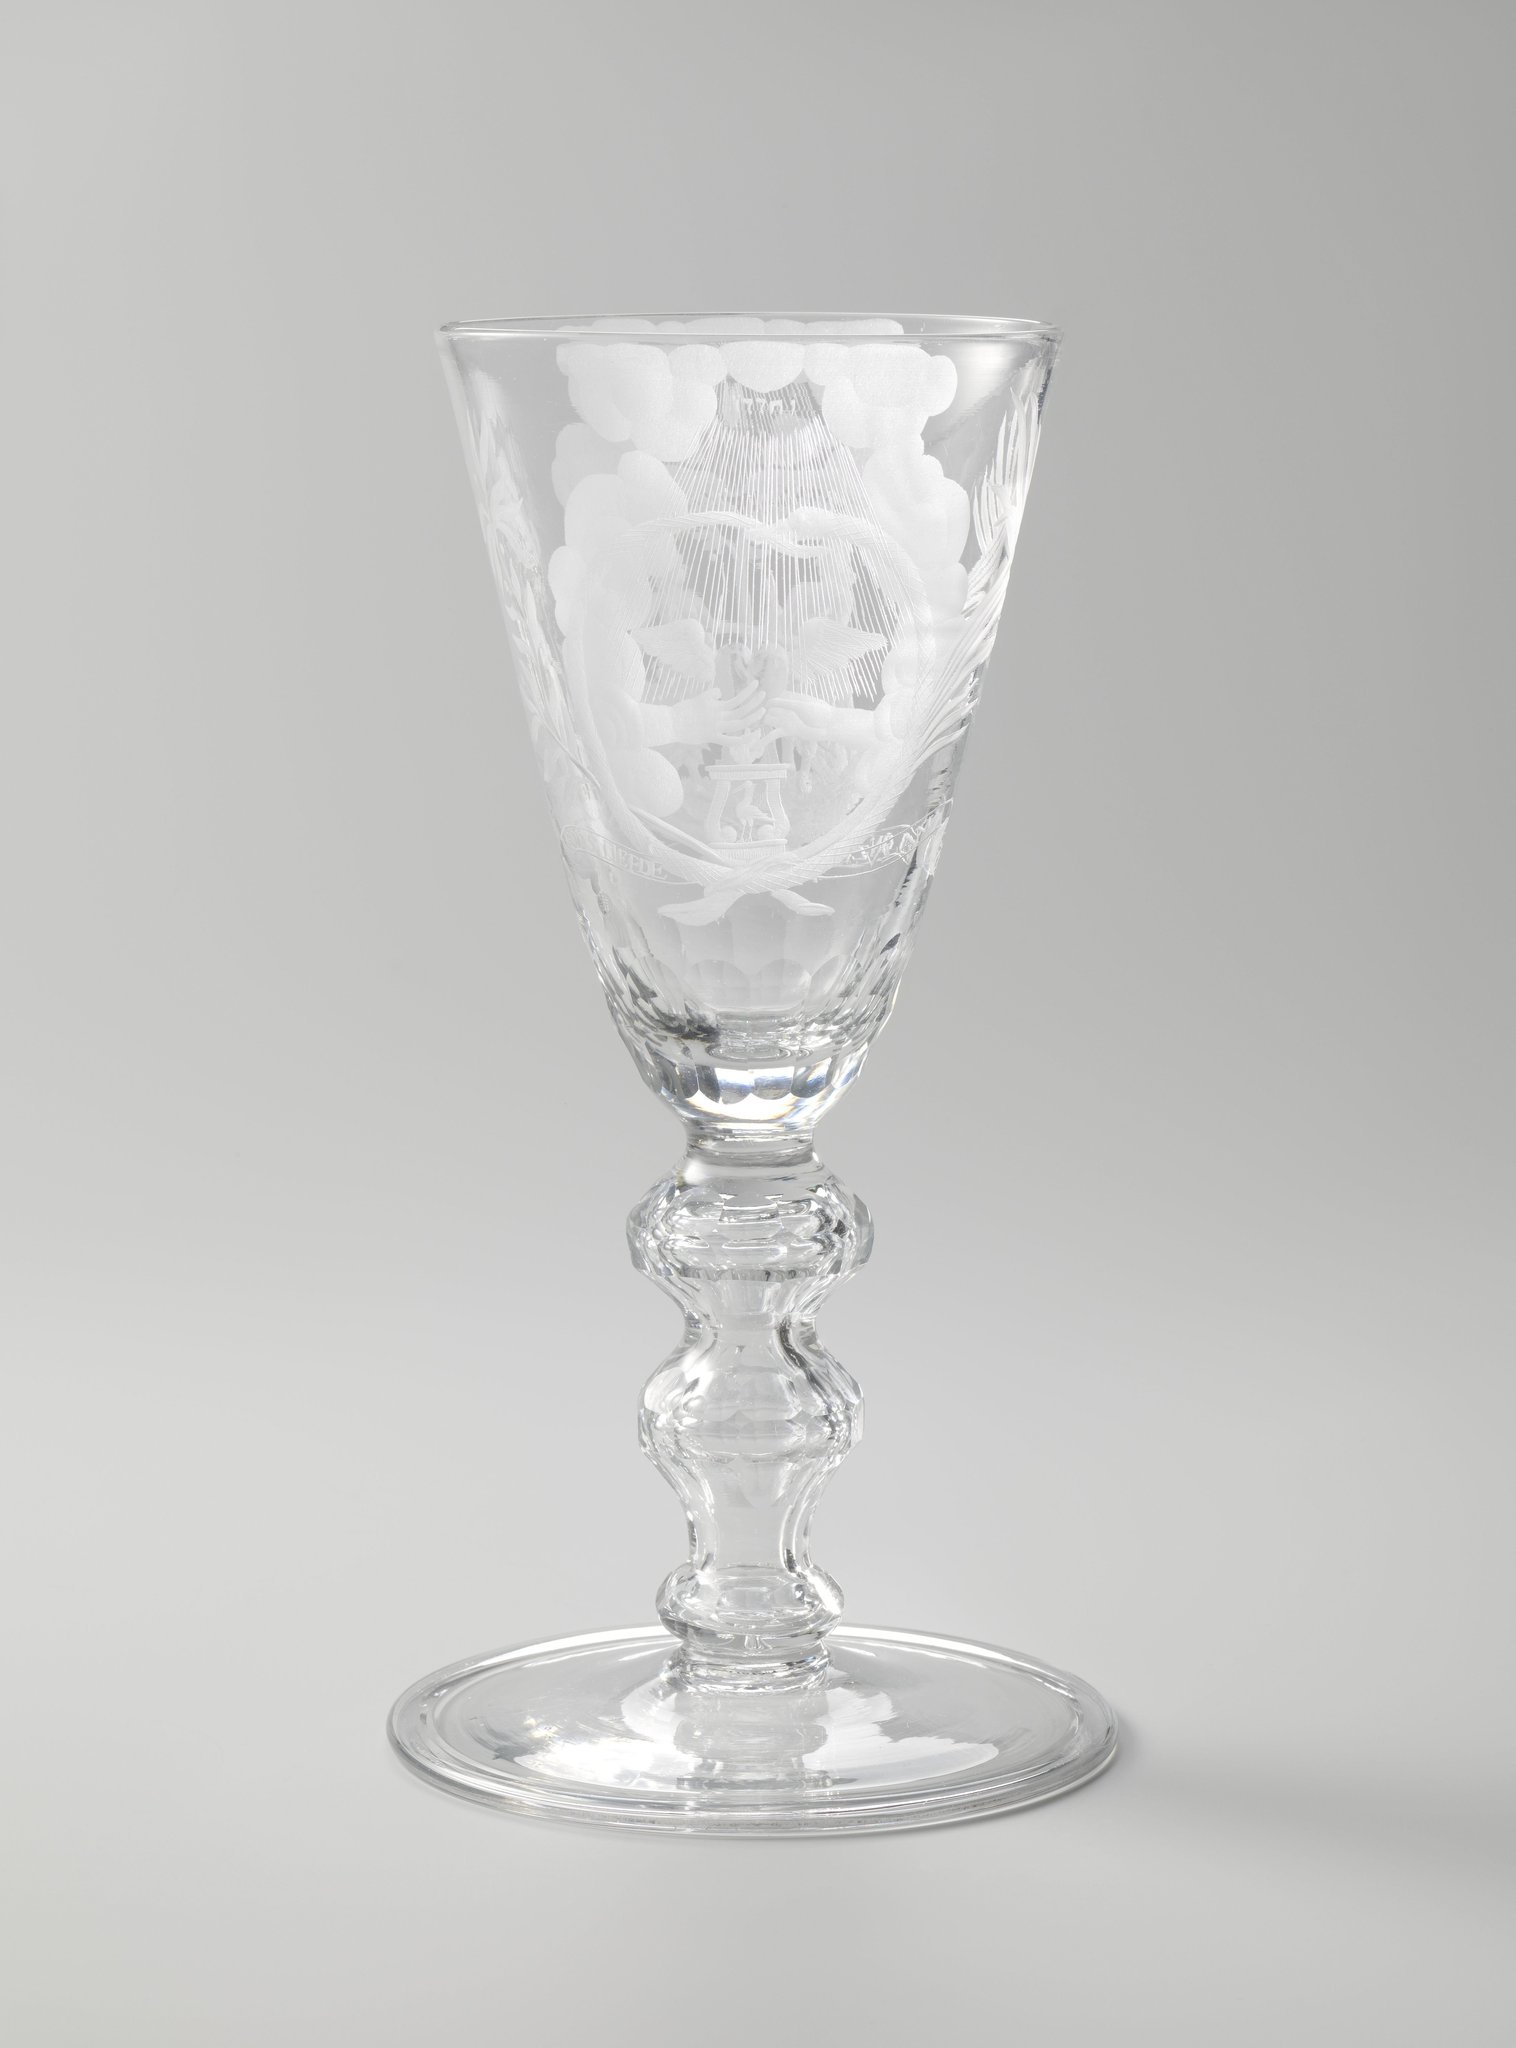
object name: goblet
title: Marriage glass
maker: Anonymous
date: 1725-1750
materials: glass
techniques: glassblowing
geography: saxony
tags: silver anniversary, serpent ouroboros, profane heart symbolism ~ love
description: translation of inscription: as God’s loving flame nourishes our kin